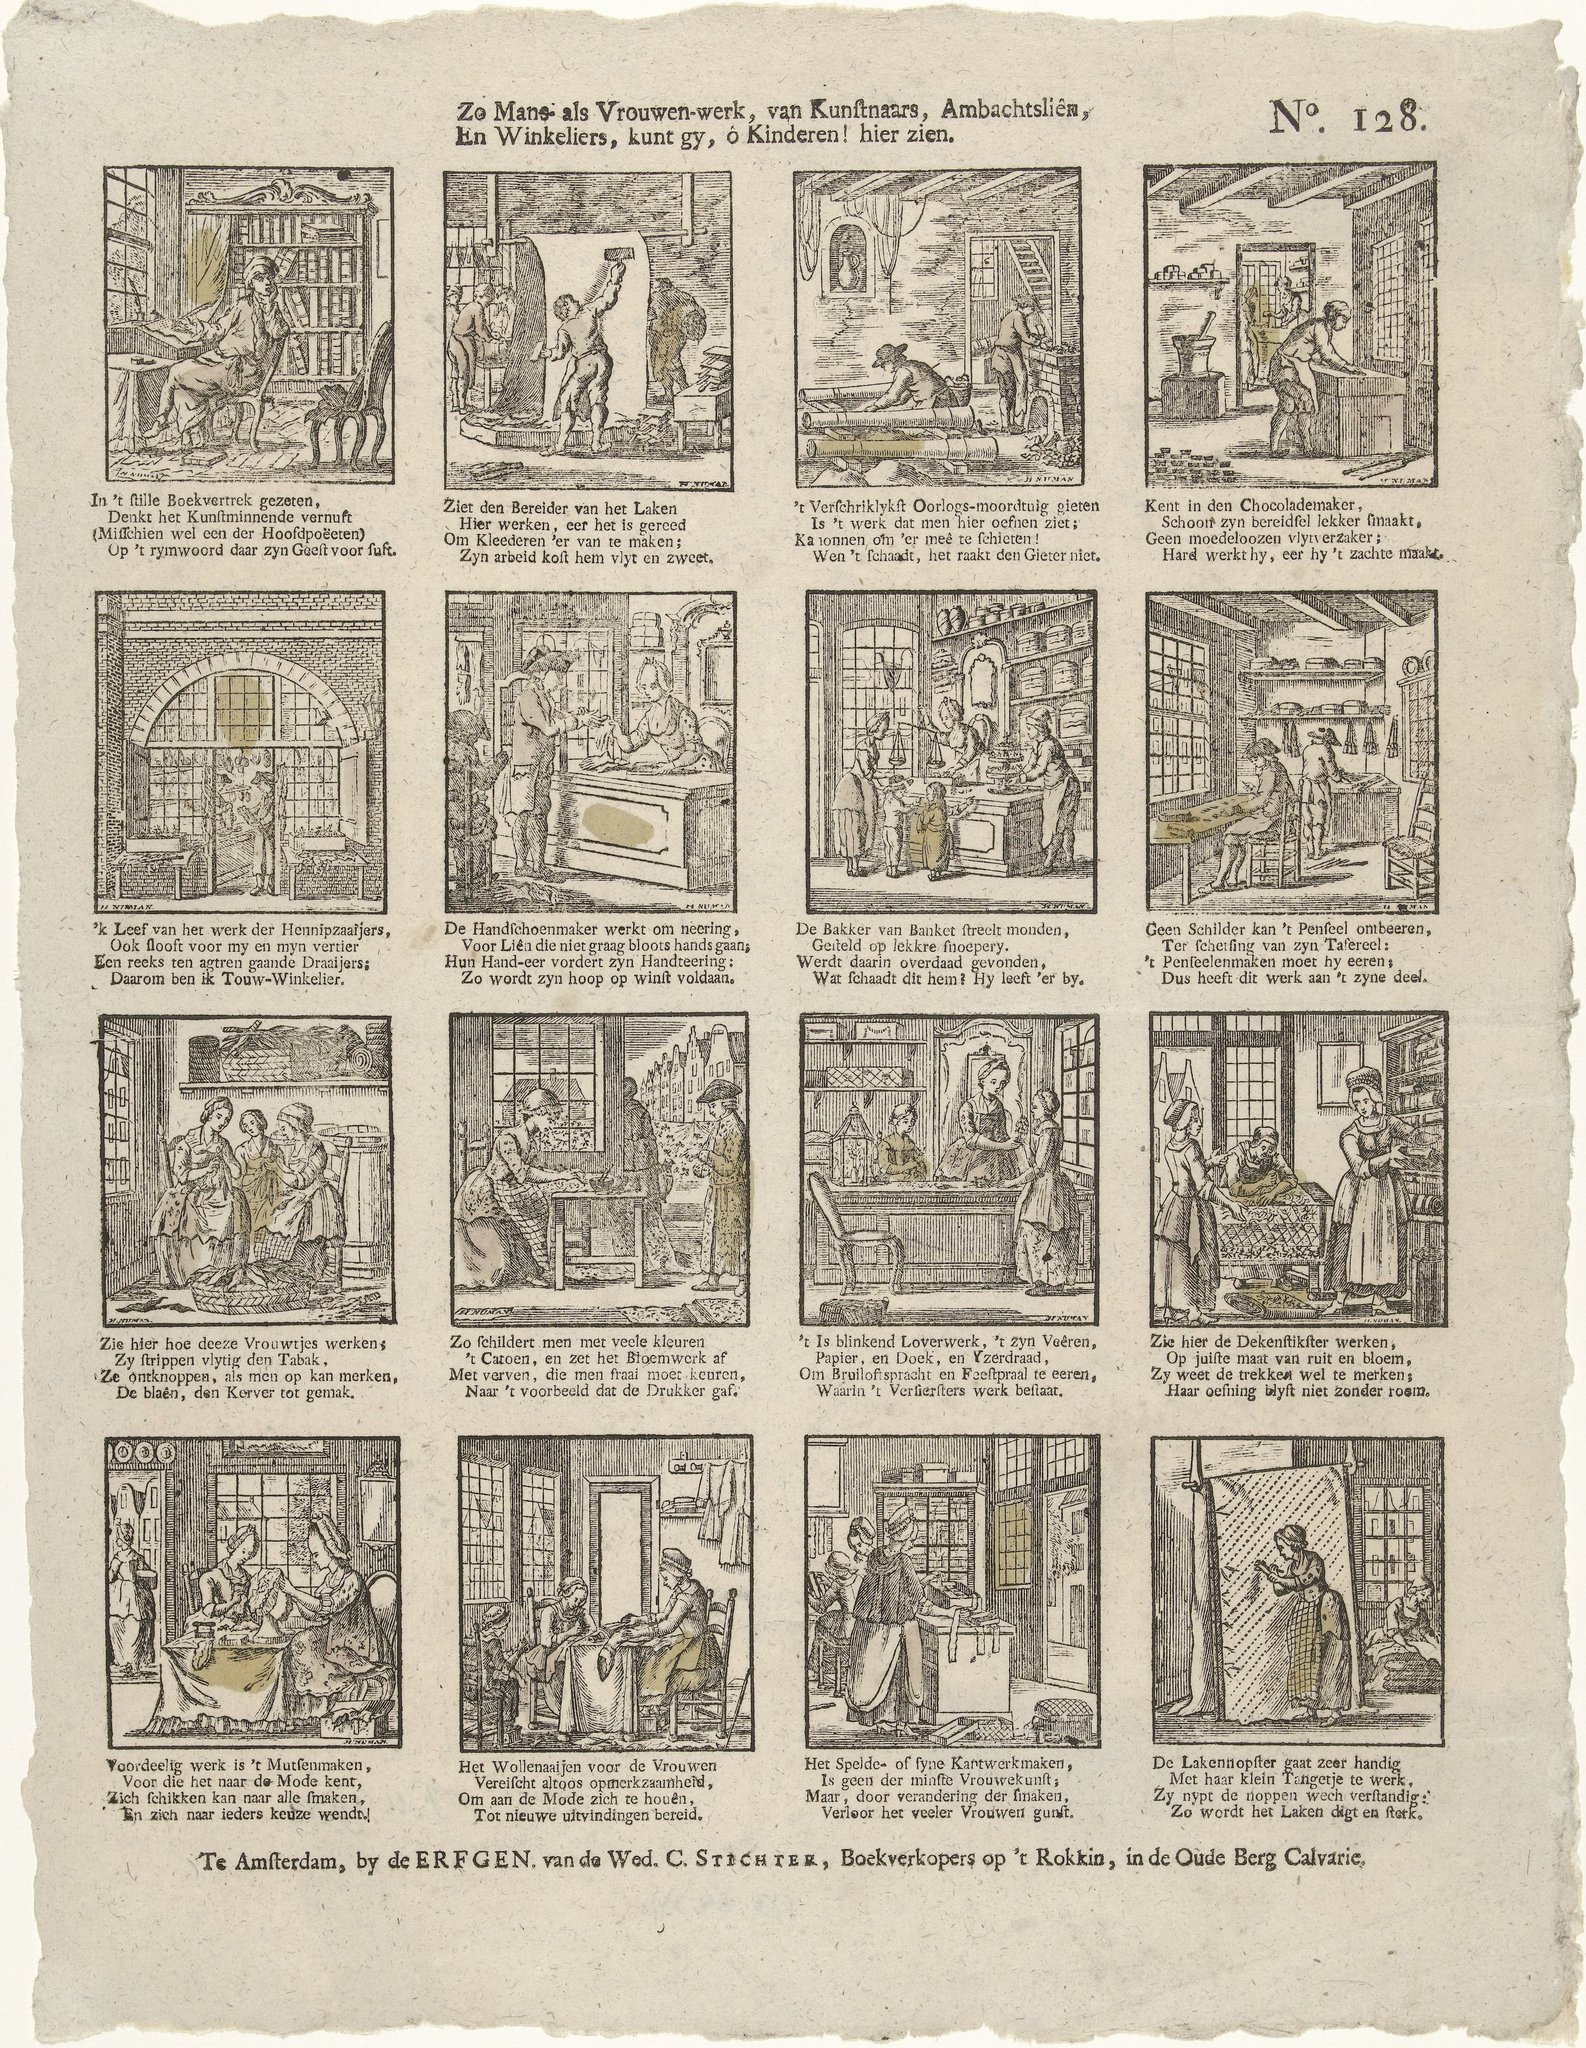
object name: popular print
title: Zo mans- als vrouwen-werk, van kunstenaars, ambachtsliên, / En winkeliers, kunt gy, ô kinderen! hier zien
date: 1770-1797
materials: paper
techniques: colour, letterpress printing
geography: amsterdam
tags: handicrafts and industries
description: Blad met 16 voorstellingen van ambachten voor mannen en vrouwen. Onder elke afbeelding een vierregelig vers. Genummerd: No. 128.